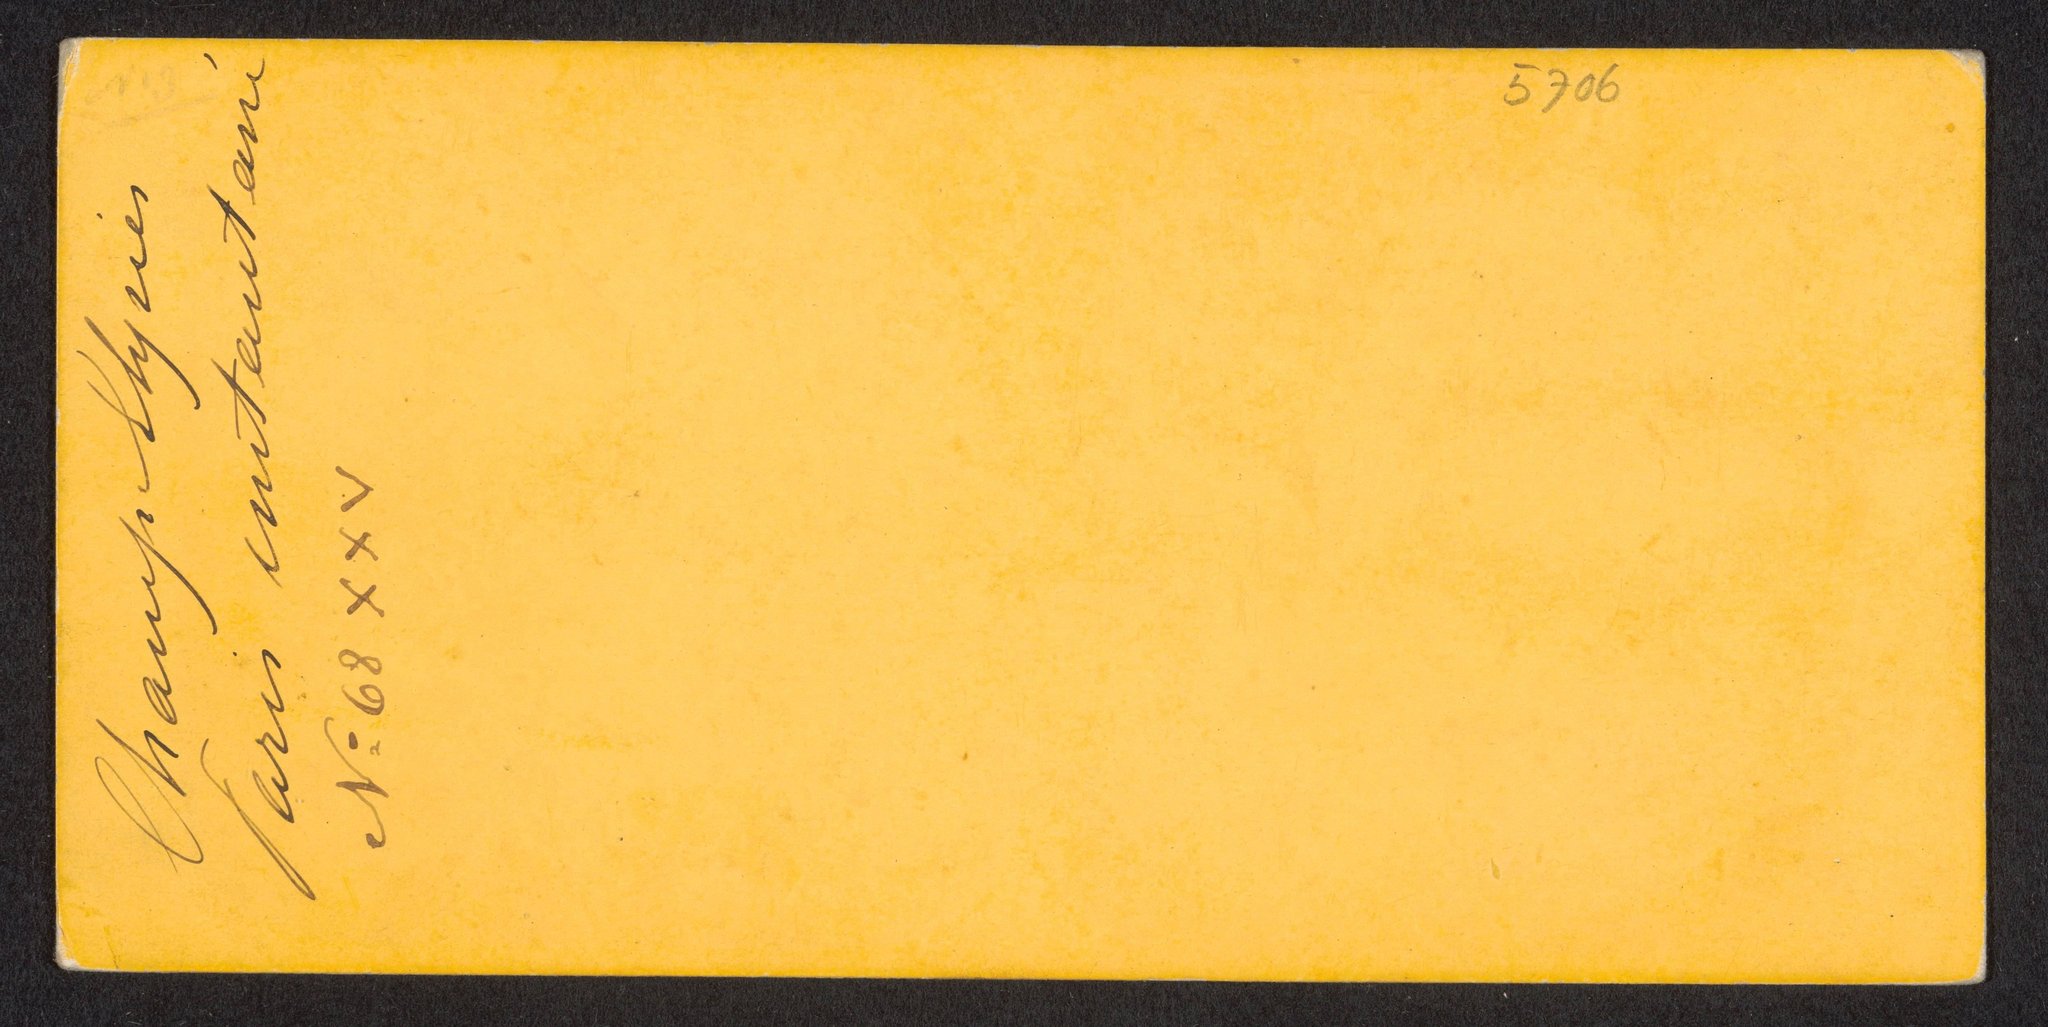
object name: stereograph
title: Gezicht op een plantsoen op de Champs-Élysées in Parijs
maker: Anonymous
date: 1850-1880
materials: cardboard, photographic support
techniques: albumen print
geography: paris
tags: plantation, street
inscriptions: number: ‘No. 68 XXV’, inscription: ‘Champs Elysées, Paris instantané’